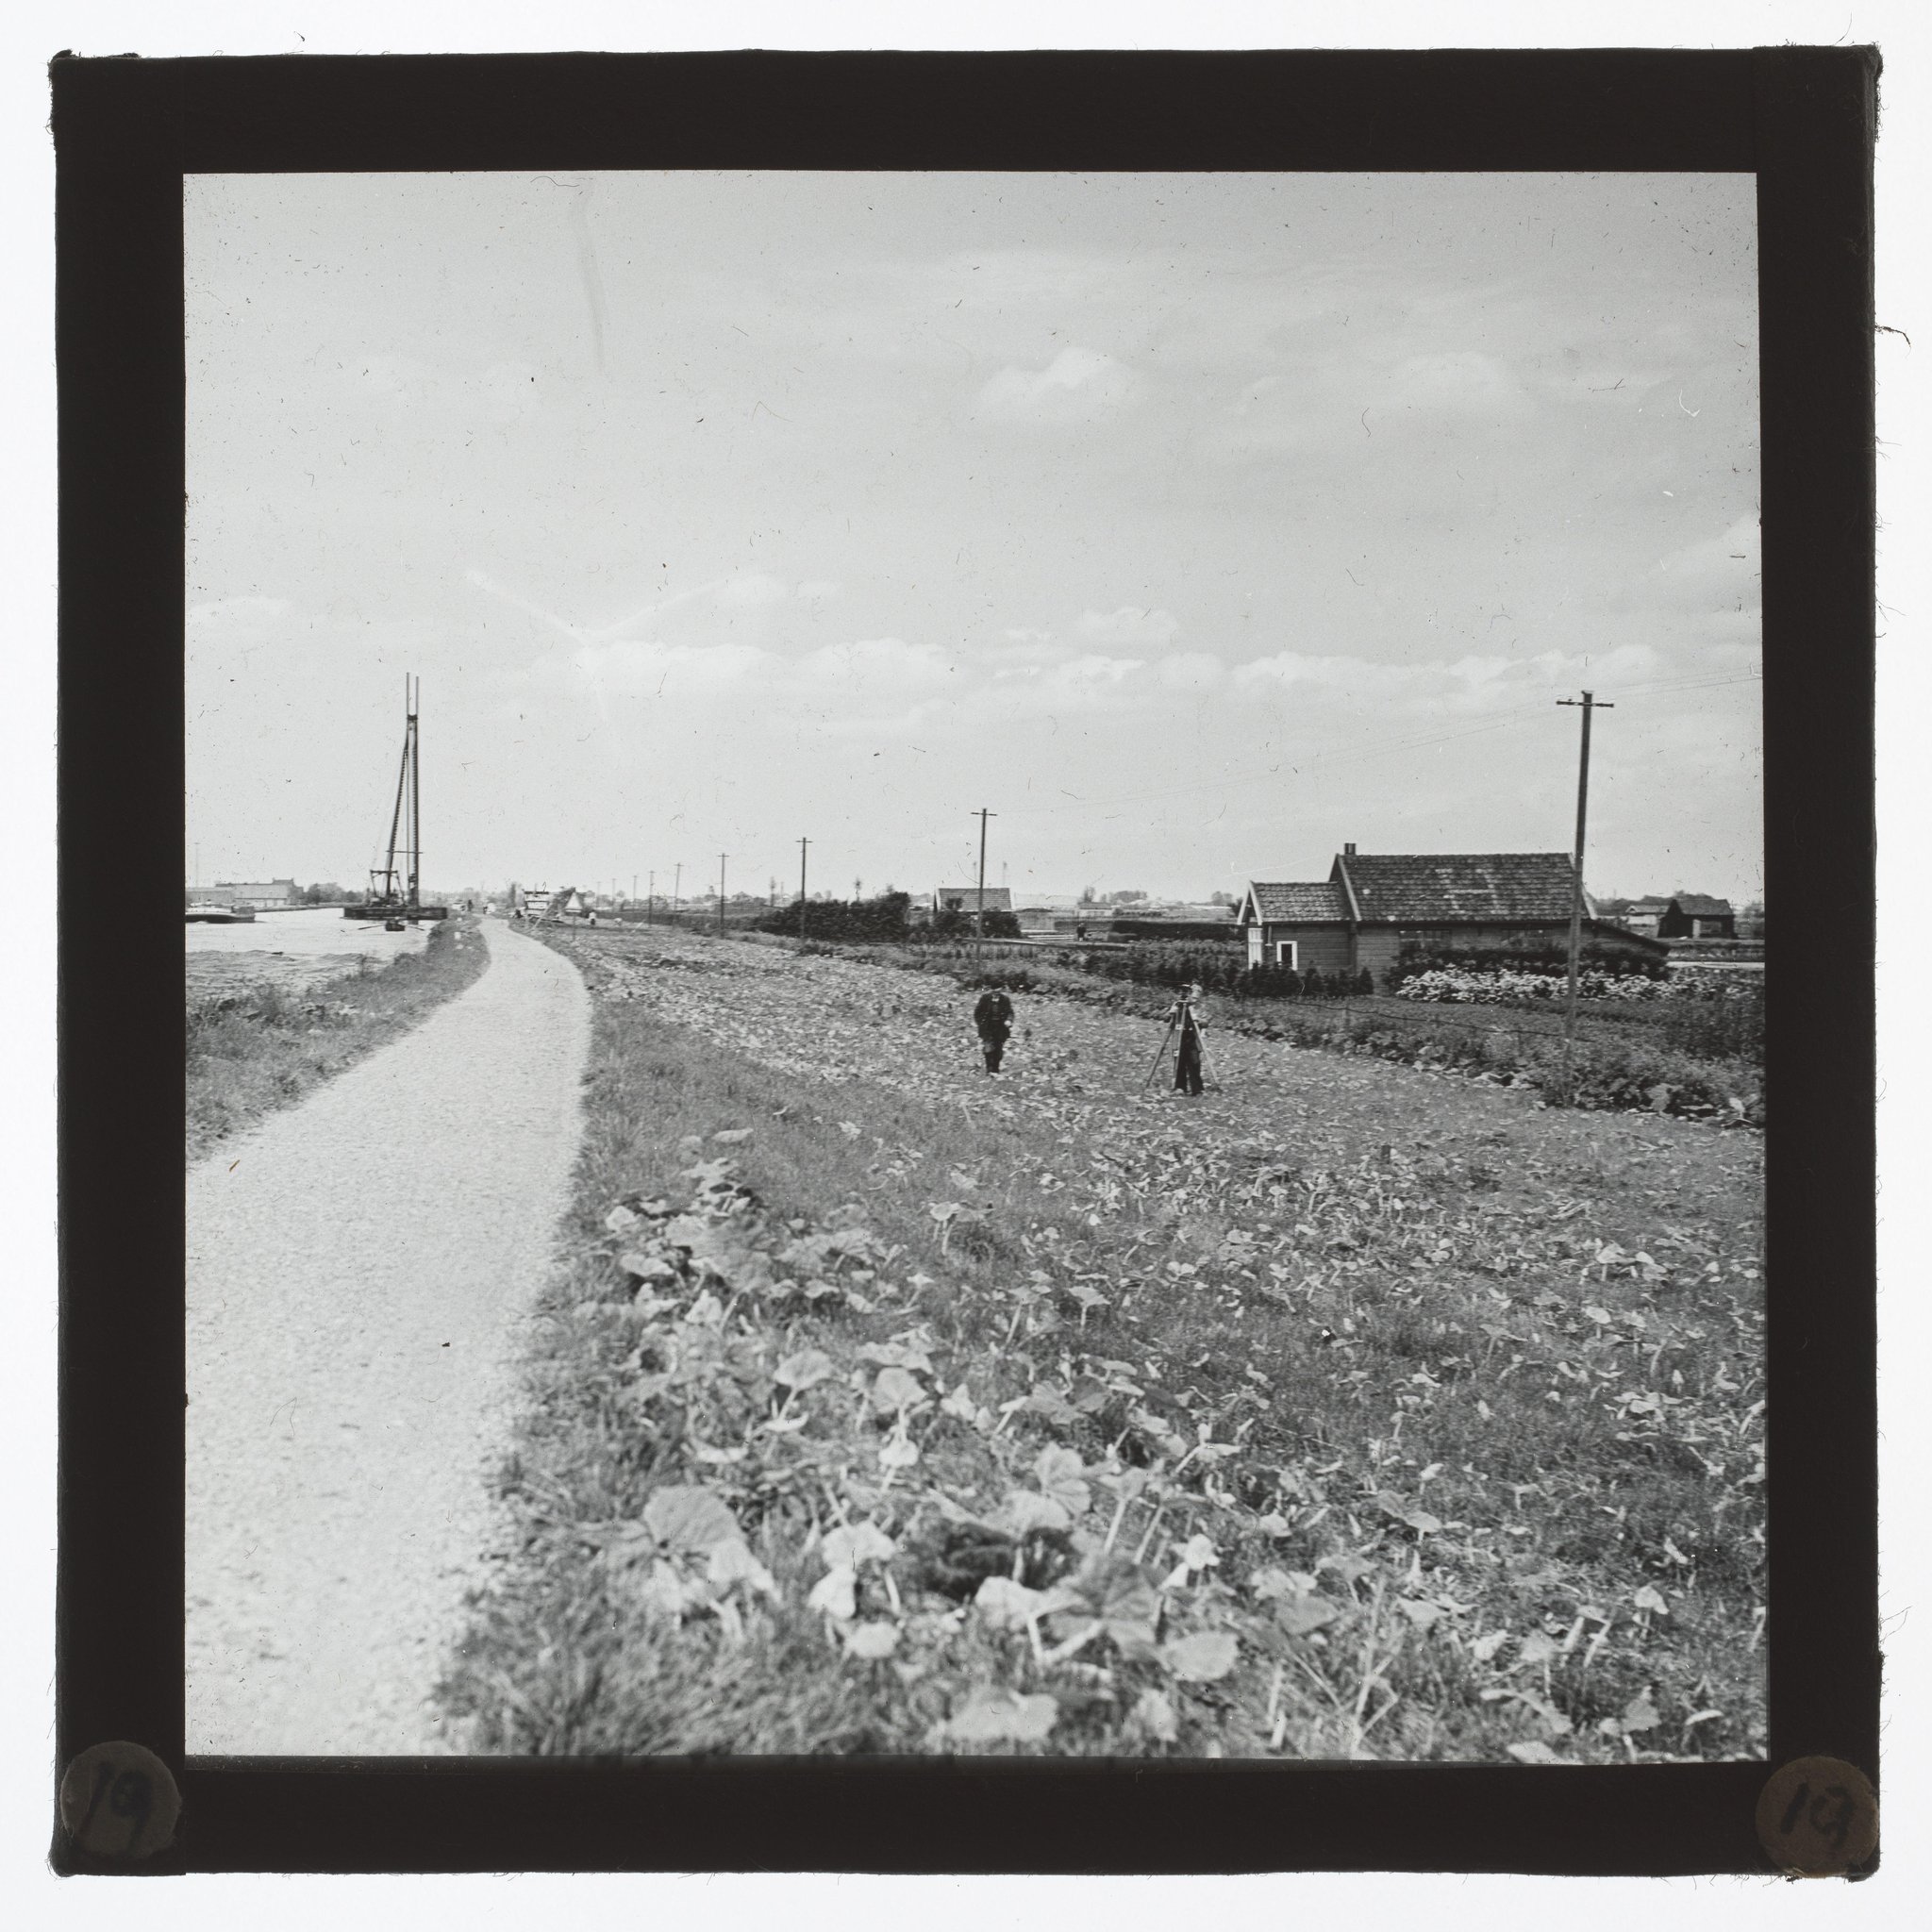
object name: lantern slide photographic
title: Landmeter langs een weg in Zuid-Holland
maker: Anonymous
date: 1956-1960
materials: glass, paper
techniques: gelatin silver transparency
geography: south holland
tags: instruments used in geodesy, surveying instruments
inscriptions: number: ‘19’